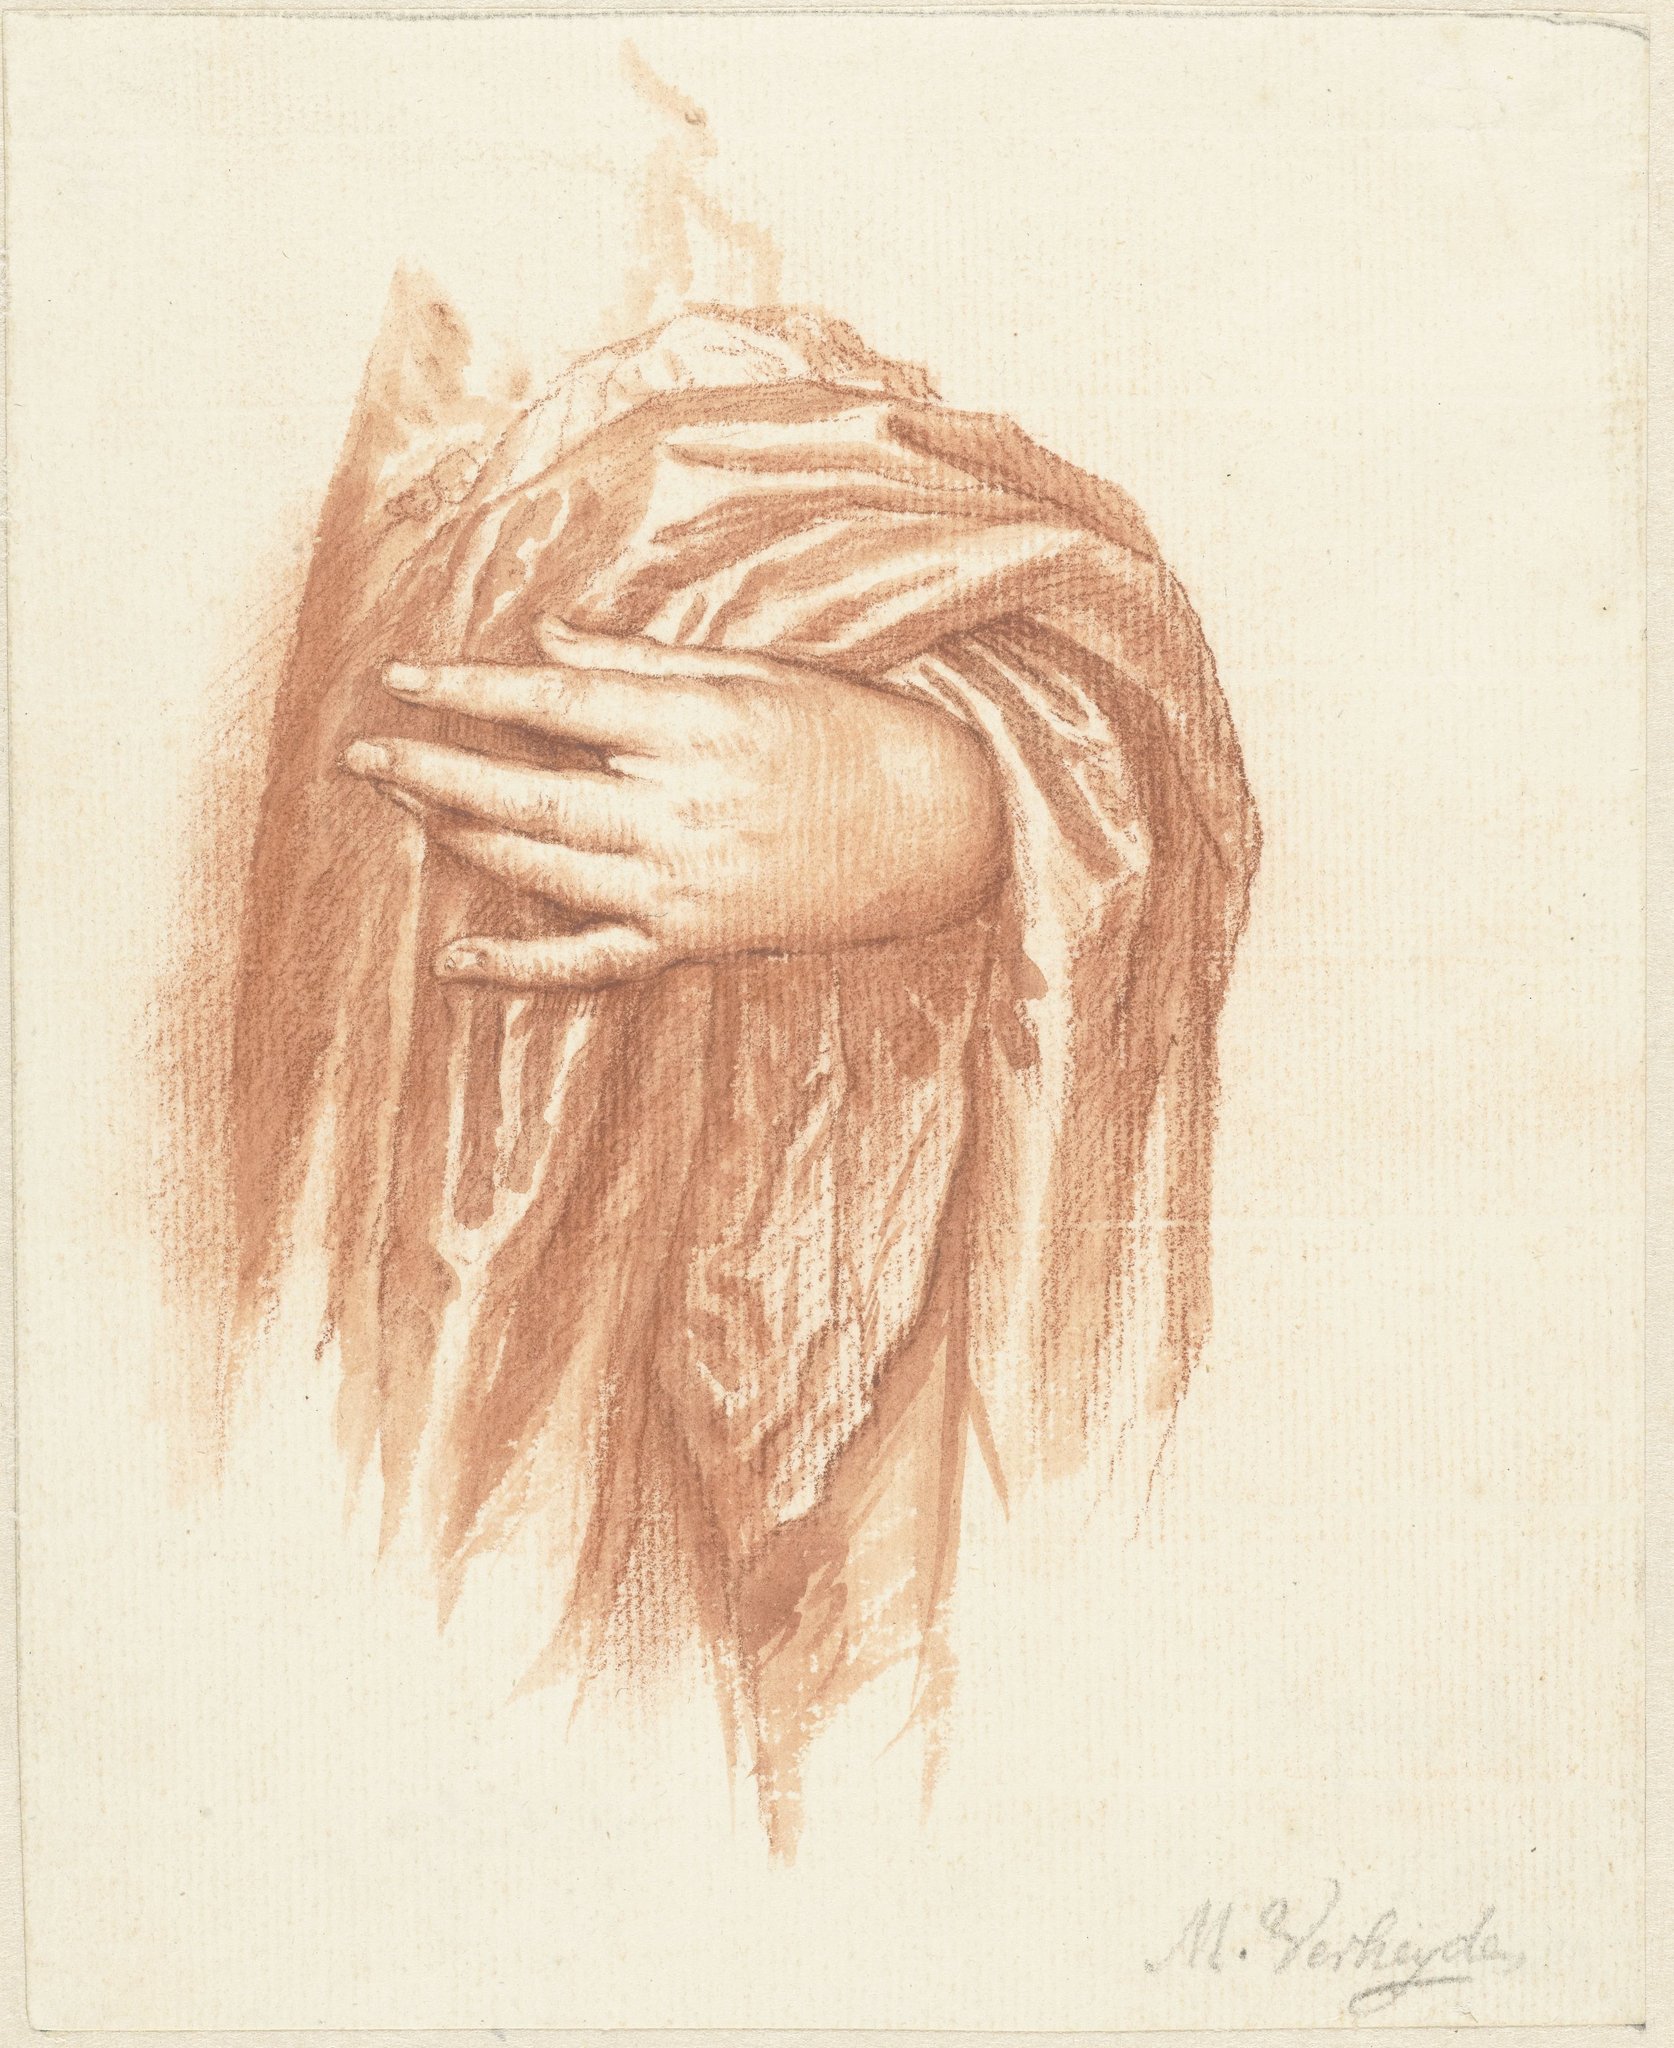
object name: drawing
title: Studie van een linkerhand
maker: mattheus verheyden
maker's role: draughtsman, painter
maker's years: 1700-1777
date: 1710-1777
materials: chalk, paper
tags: hand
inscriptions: signature: ‘M. Verheyden.’